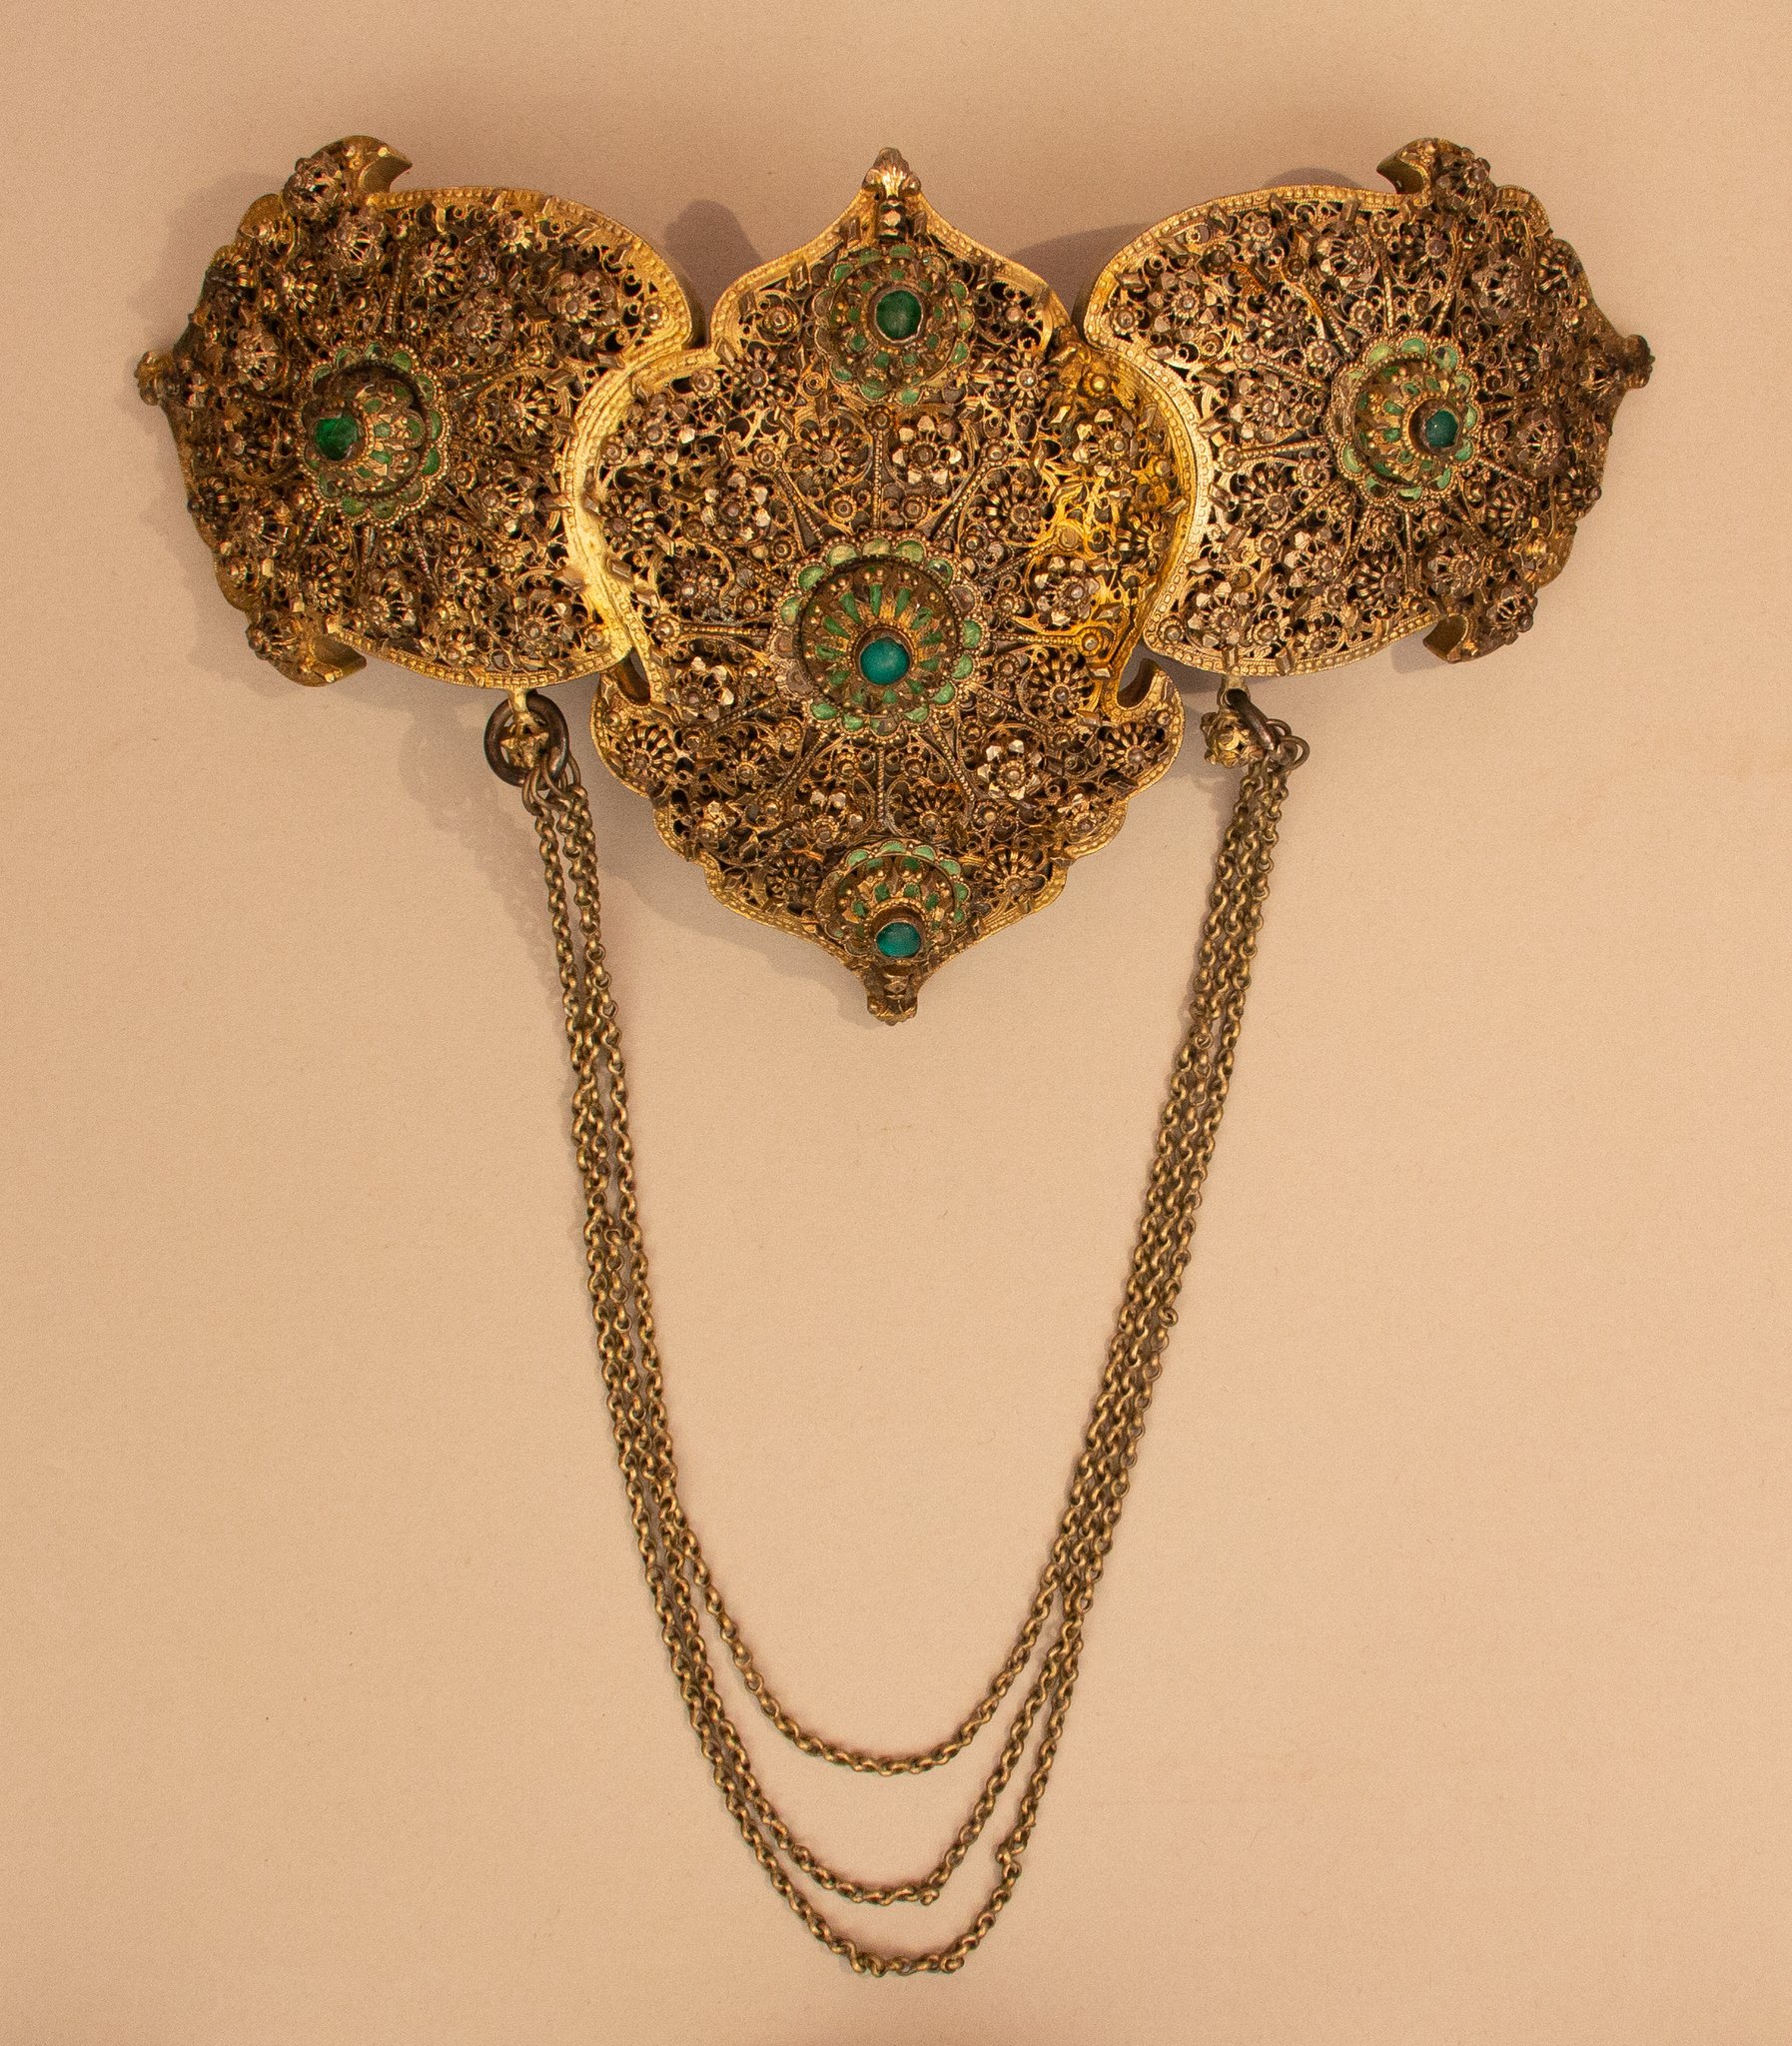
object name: clasp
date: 1701-1900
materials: enamel, silver, stone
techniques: gilding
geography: turkey